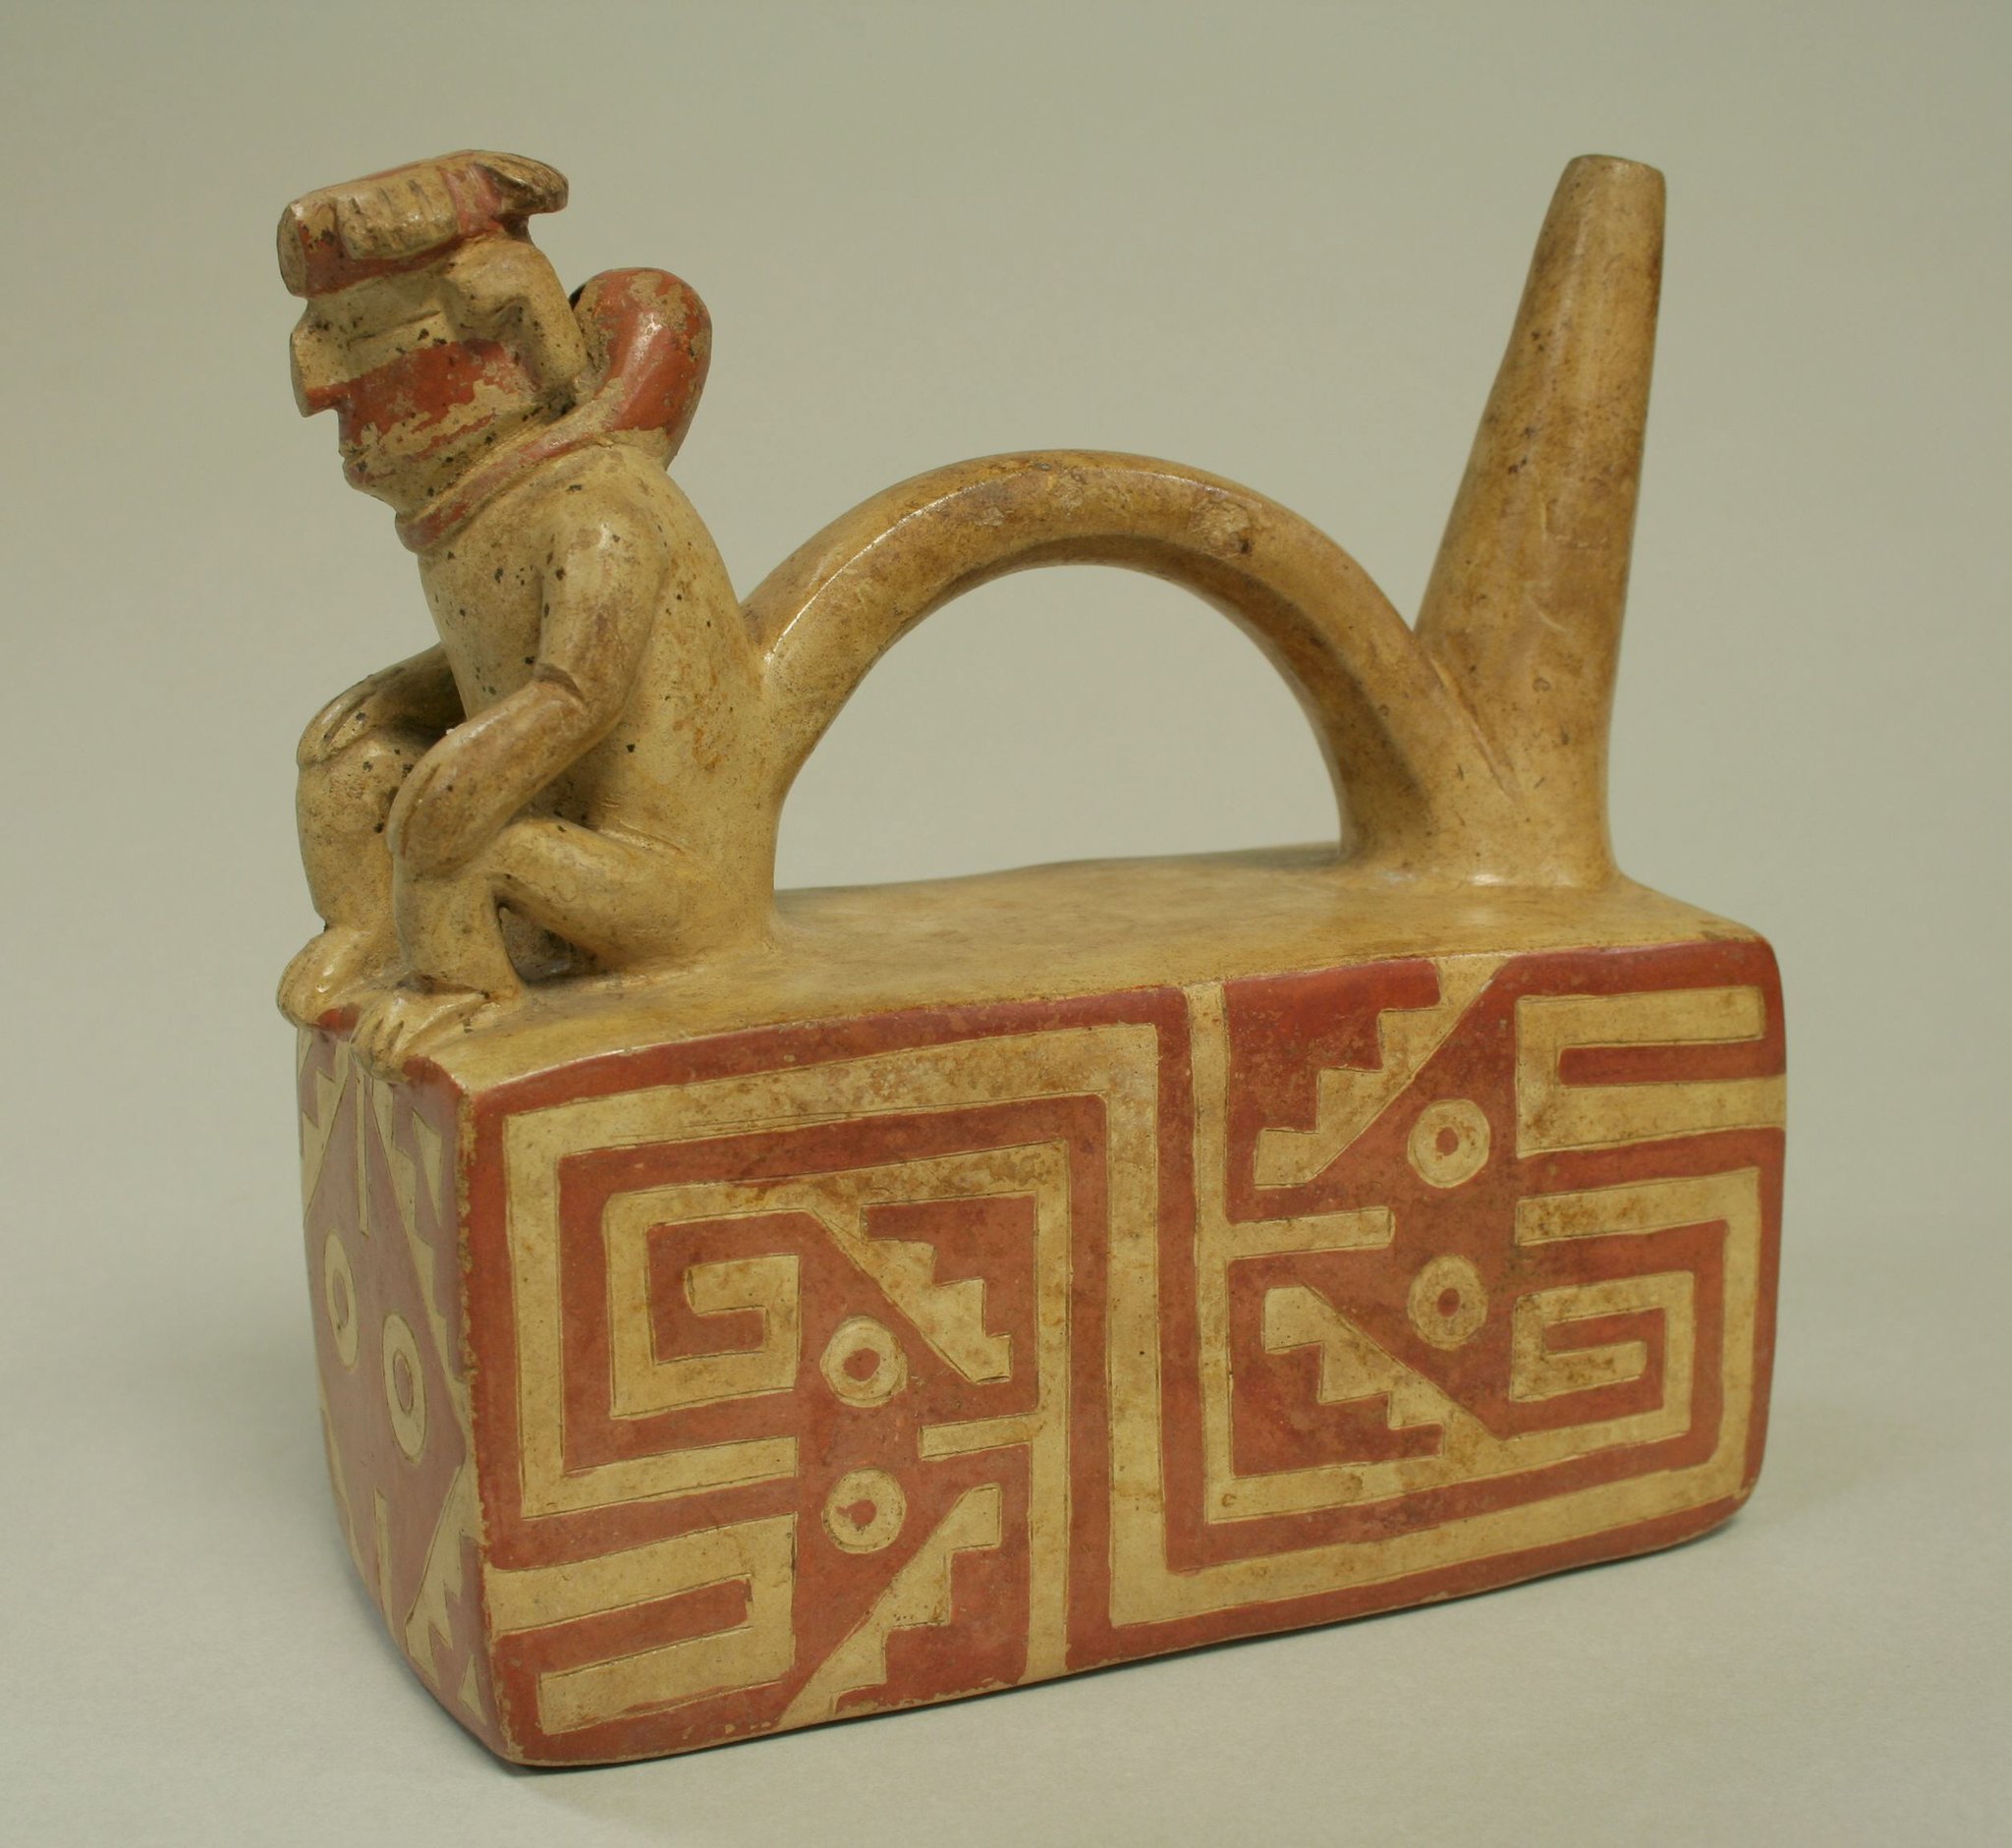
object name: bottle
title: Bridge and Spout Bottle with Figure on Throne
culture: viru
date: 101-200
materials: ceramic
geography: peru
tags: human figures